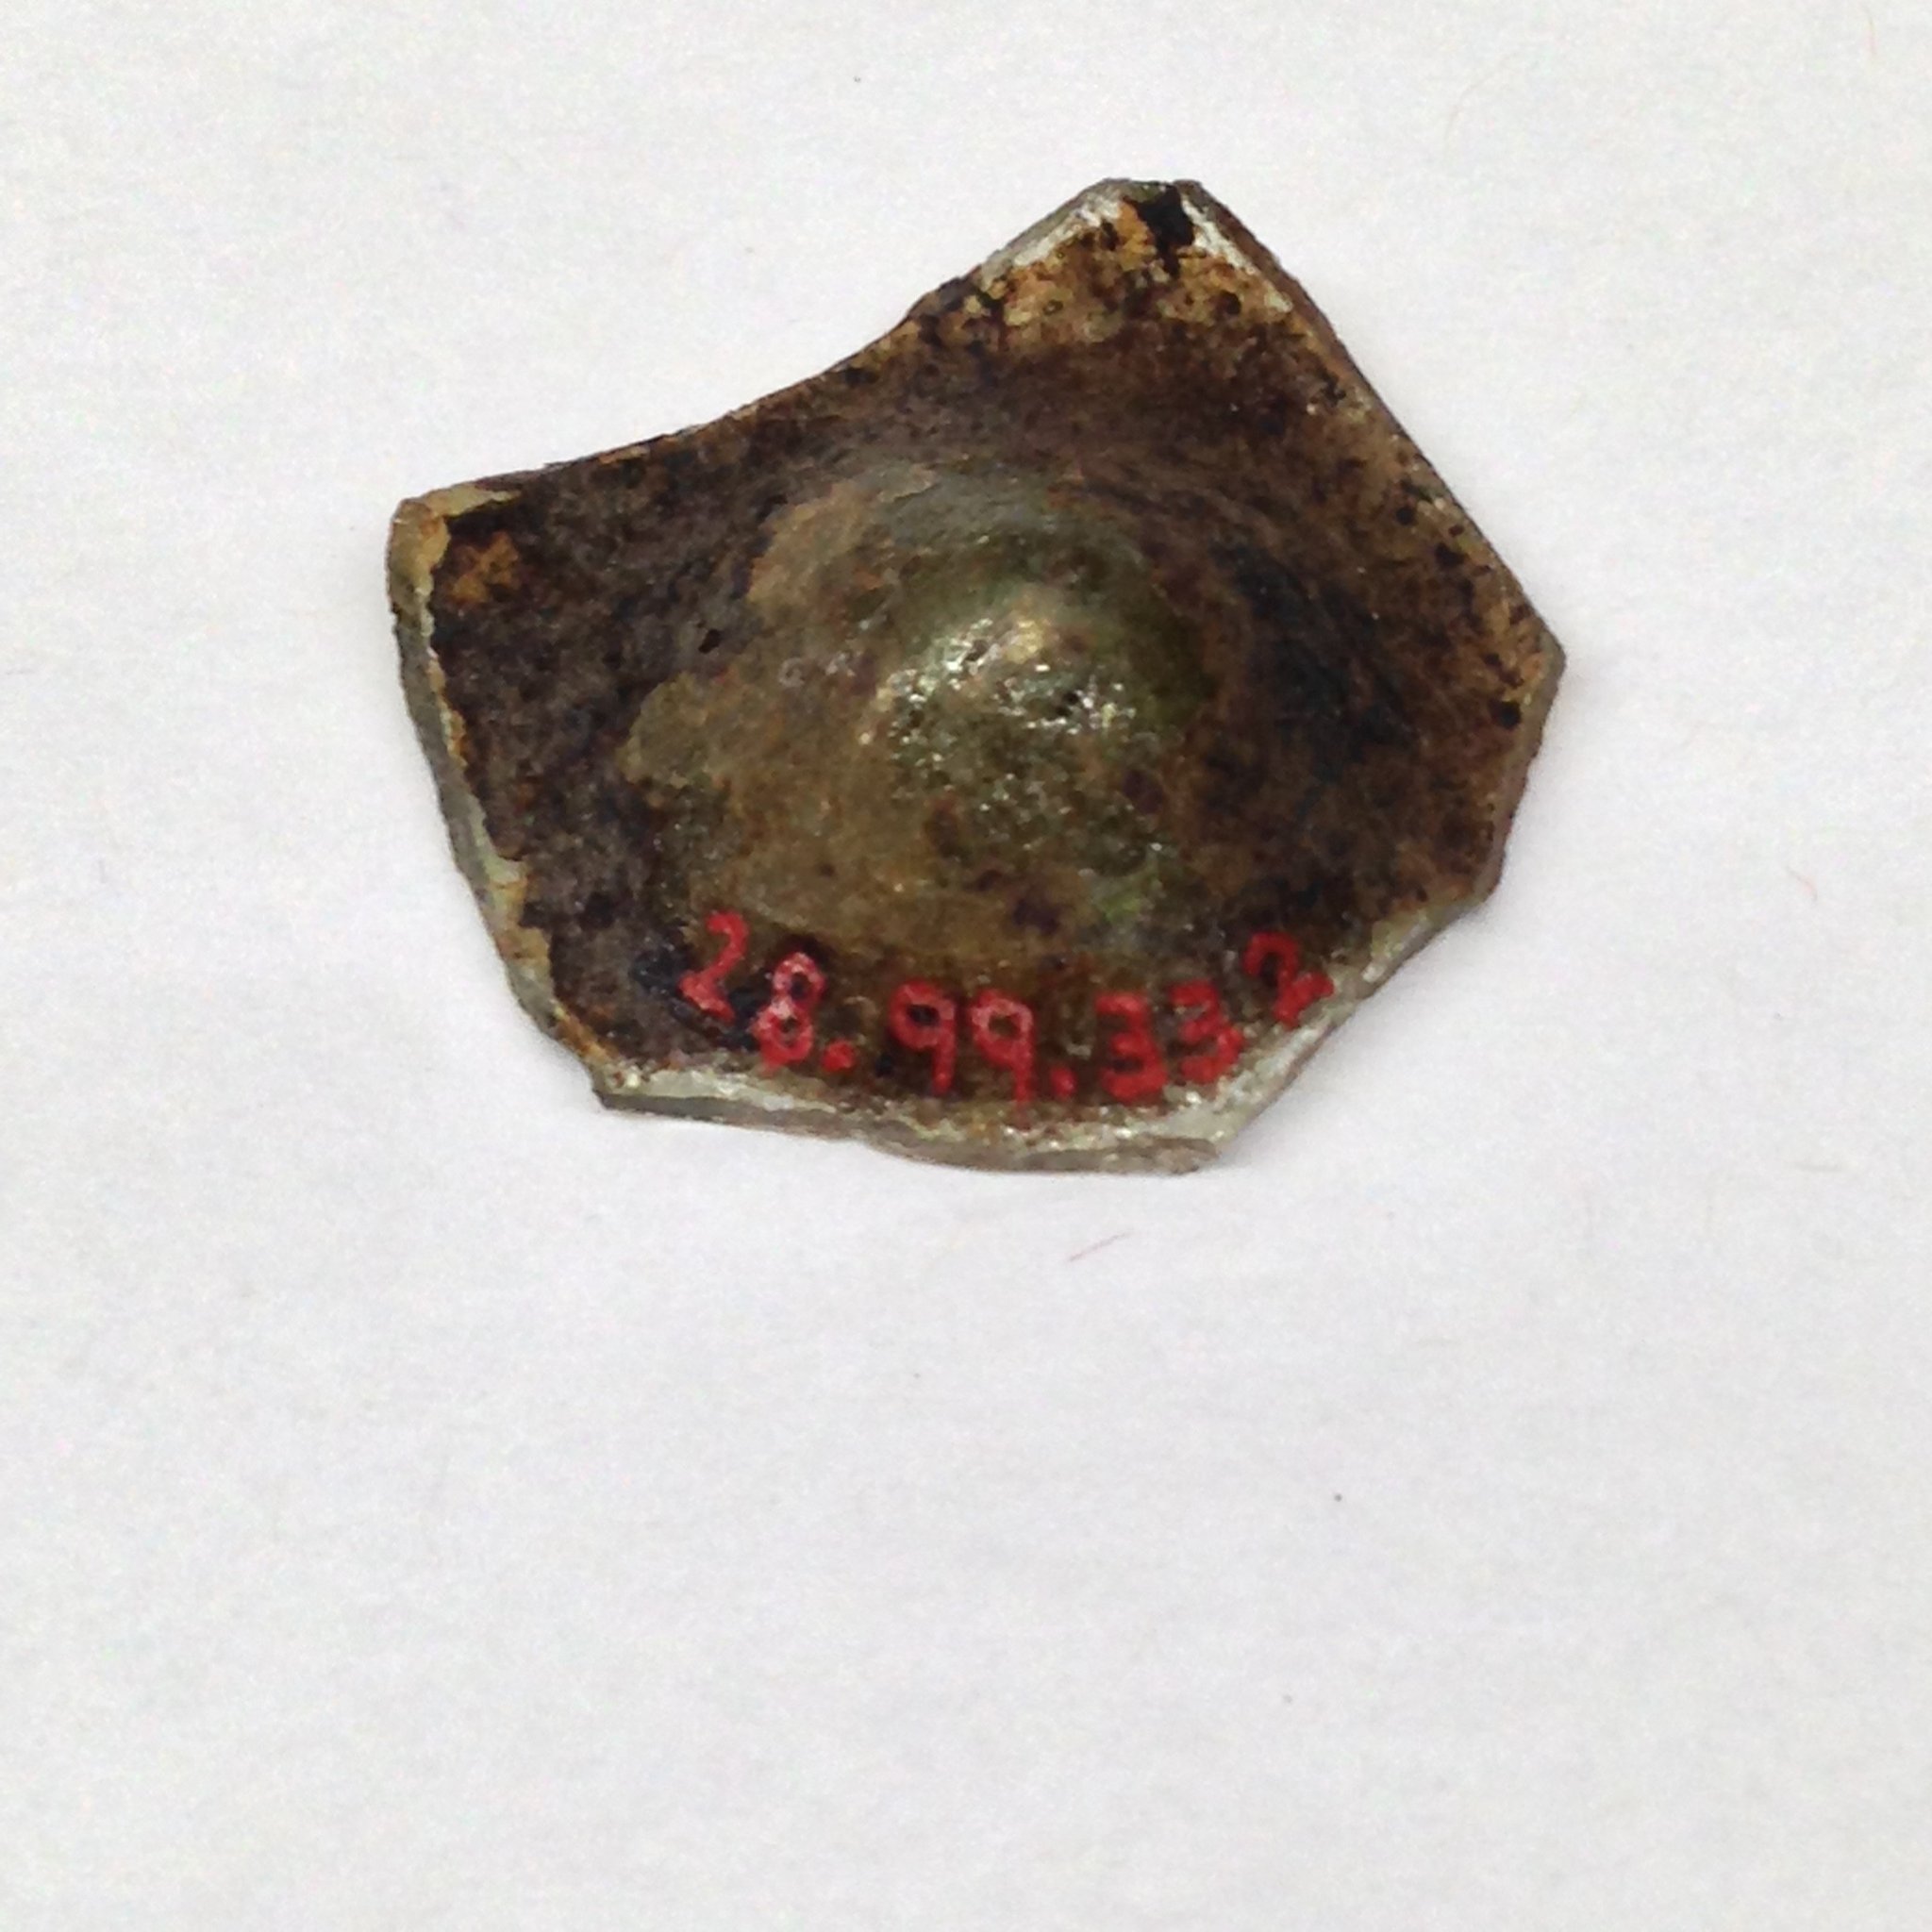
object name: fragment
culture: european or middle eastern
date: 1150-1250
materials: ceramic, glass